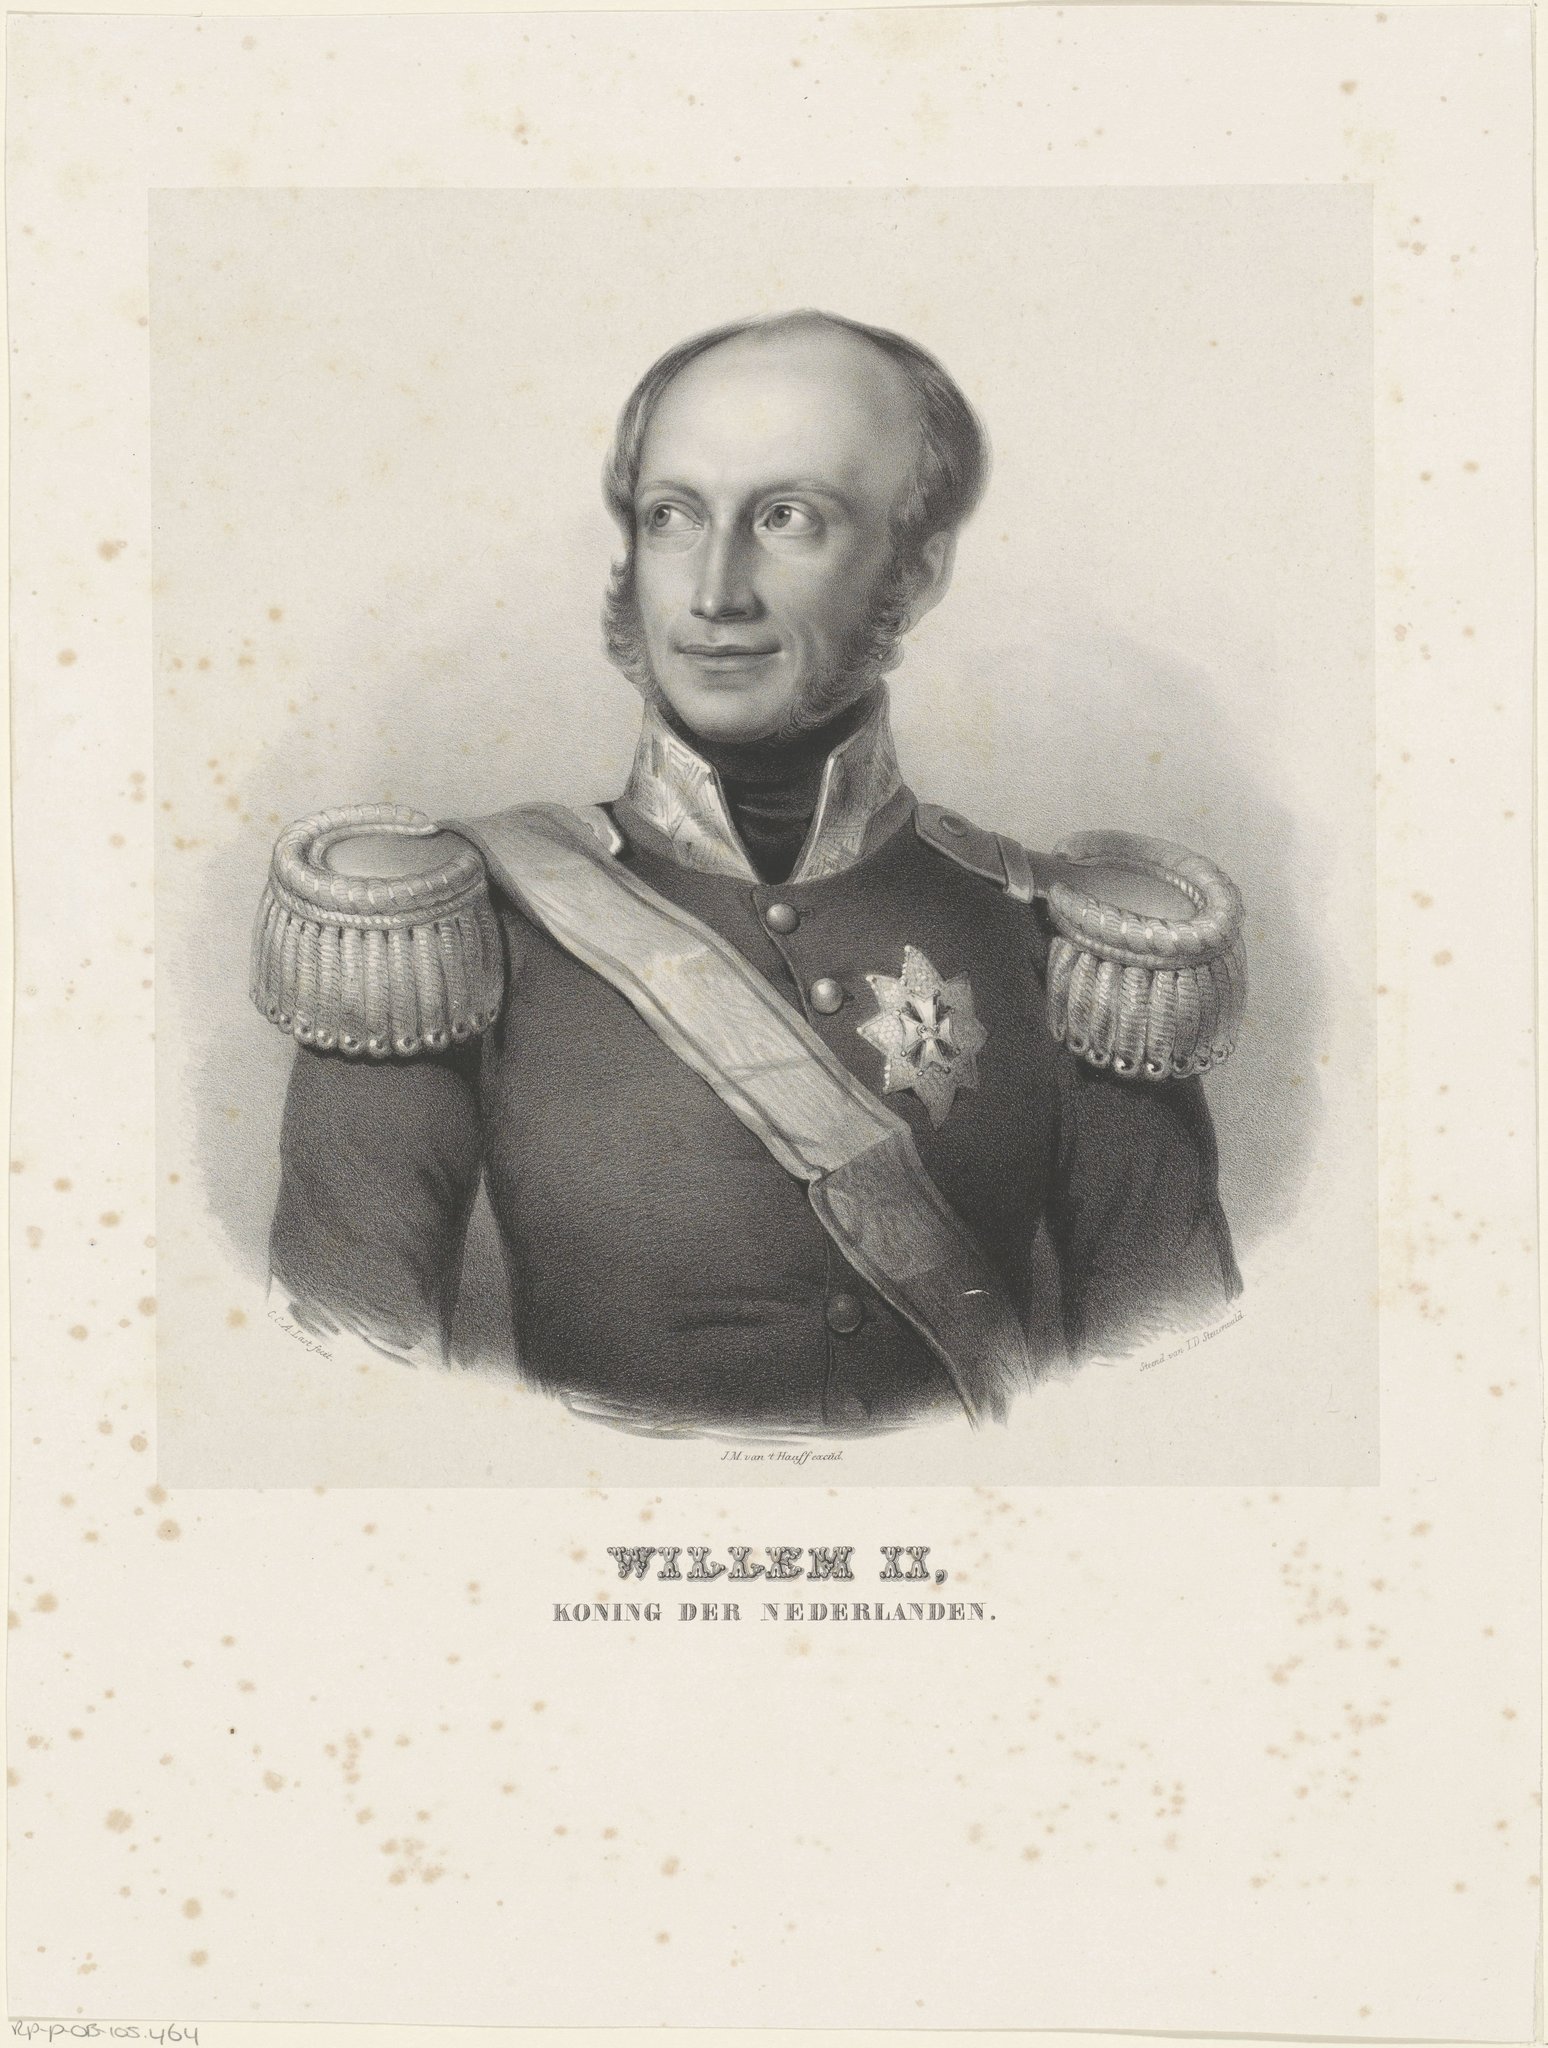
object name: print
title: Portret van Willem II, koning der Nederlanden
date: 1840-1863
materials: paper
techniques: lithograph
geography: the hague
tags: the hague, william ii of the netherlands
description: De hier vermelde titel verwijst naar de hoogst verkregen titel van de geportretteerde, niet per se naar de titel die de geportretteerde op deze voorstelling draagt.